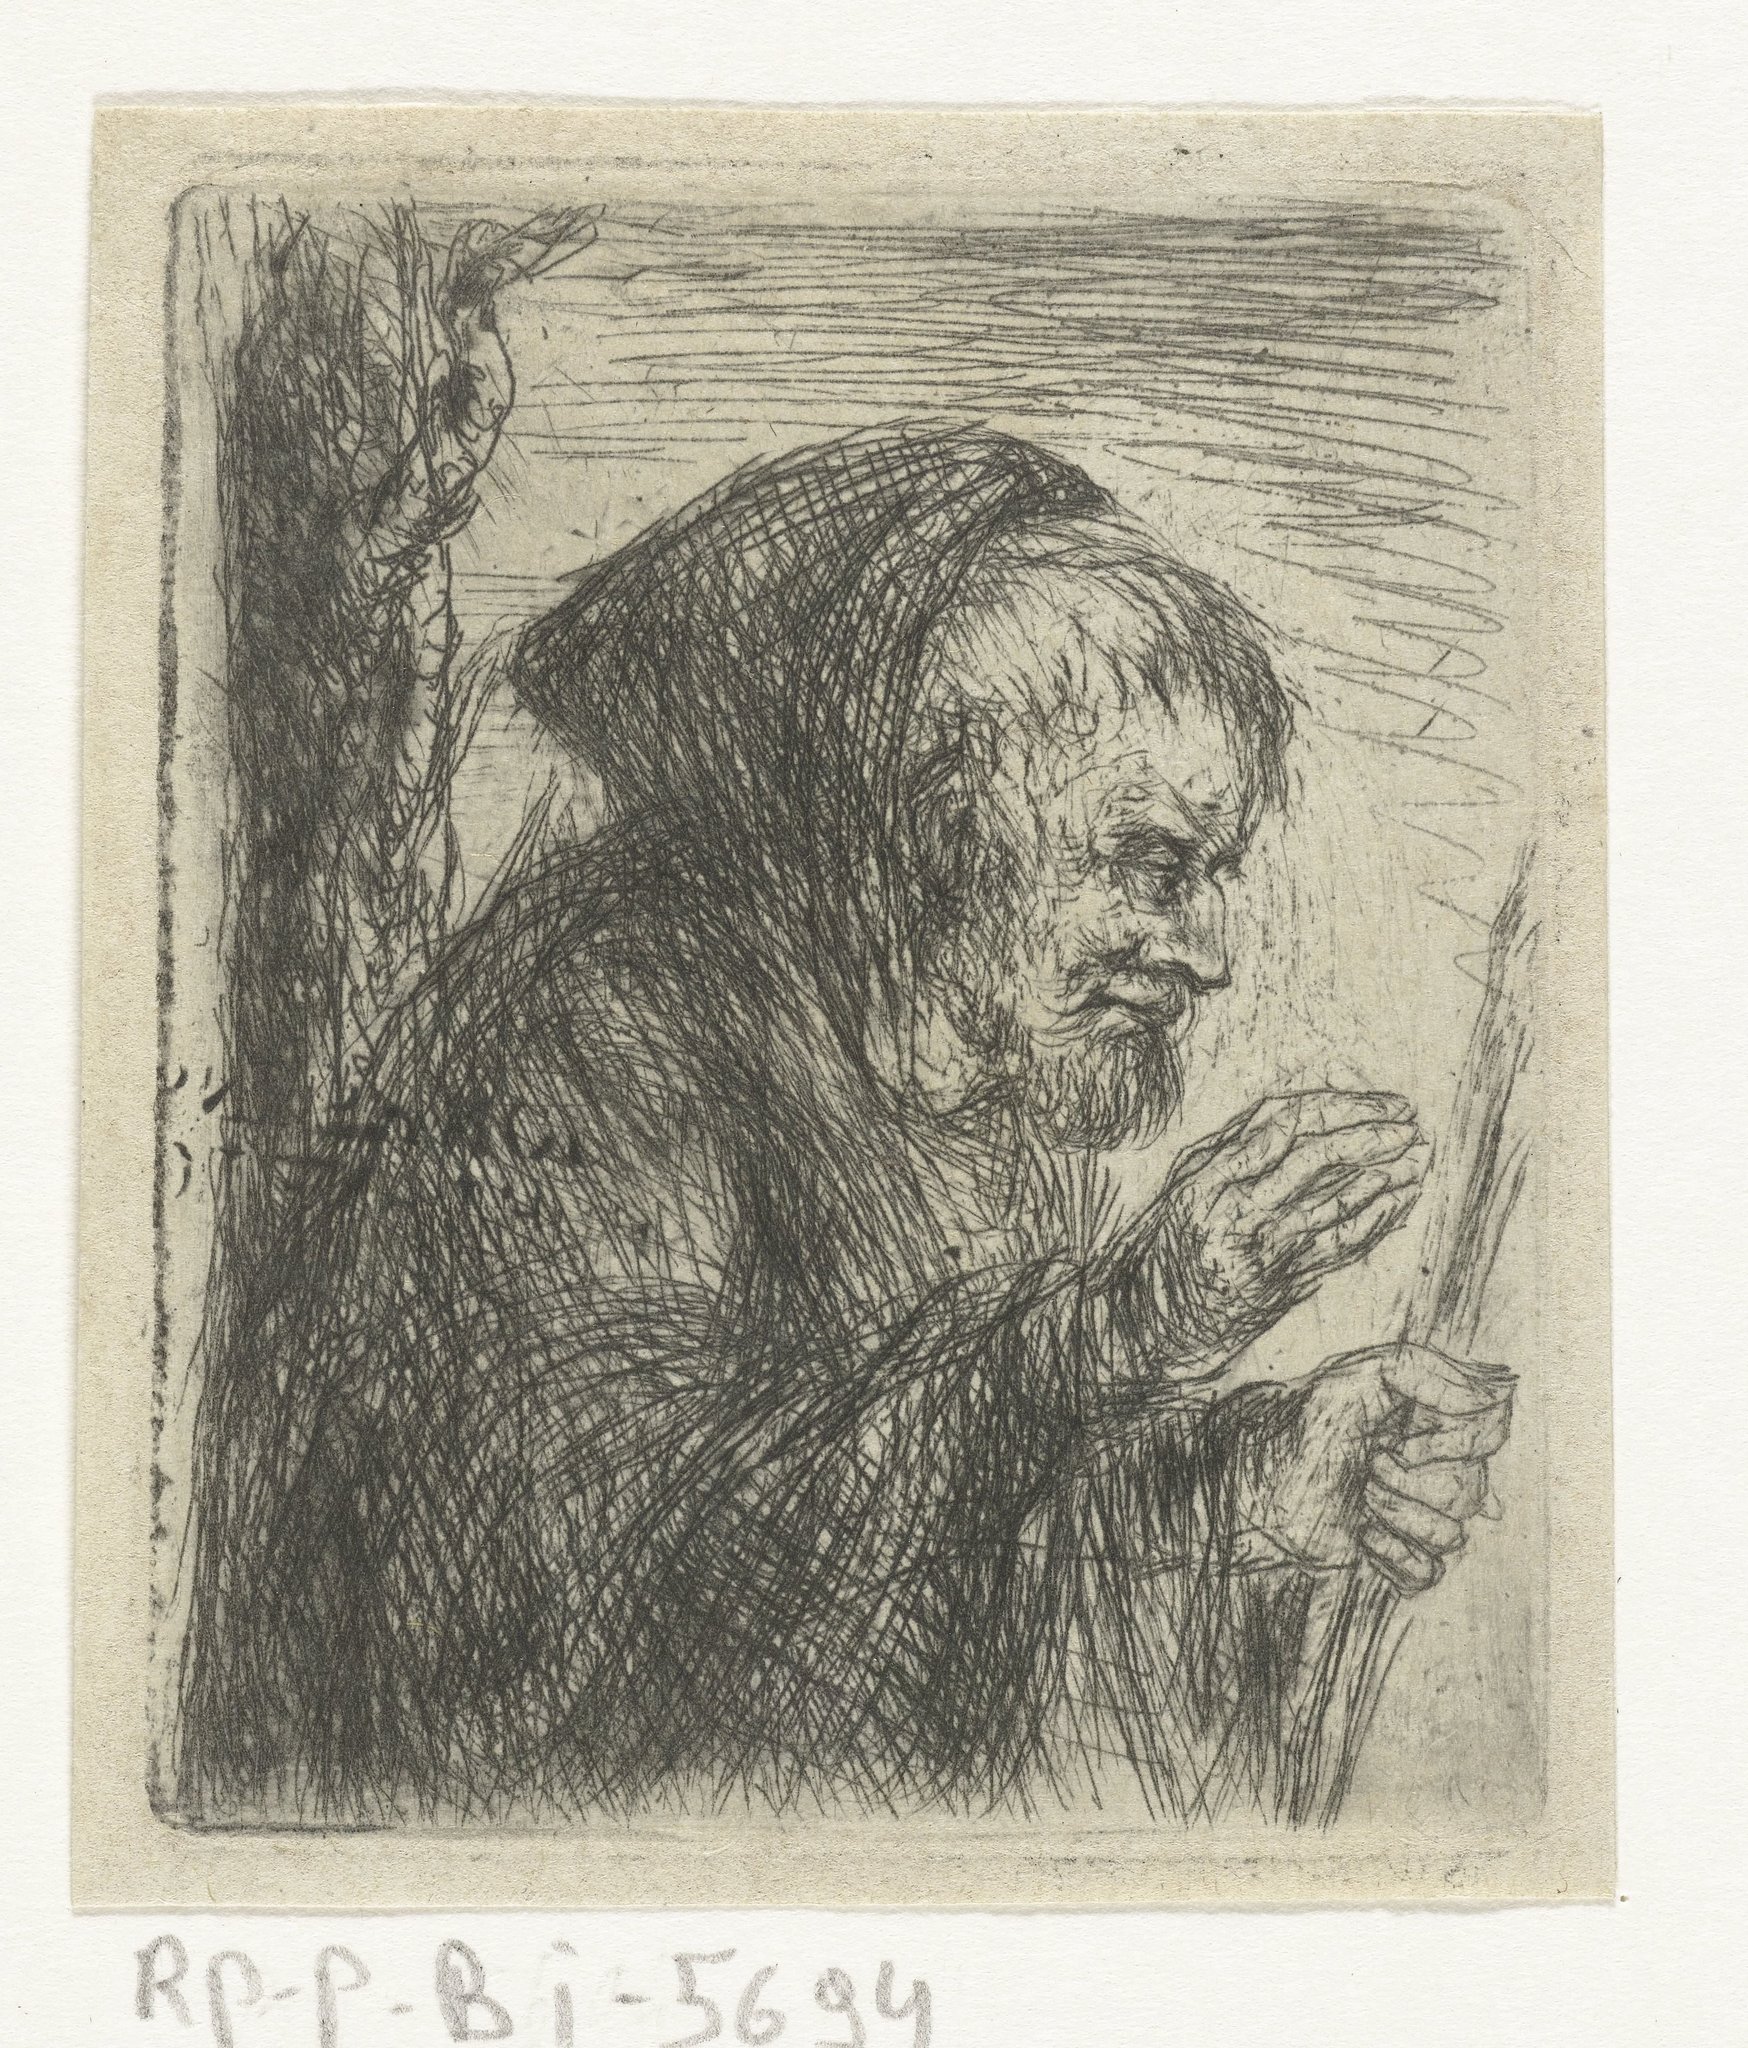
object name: print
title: Kluizenaar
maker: jan chalon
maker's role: print maker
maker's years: 1738-1795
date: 1748-1795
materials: paper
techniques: drypoint, etching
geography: northern netherlands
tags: monk(s), friar(s), anchorite, hermit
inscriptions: collector's mark: Lugt 2227